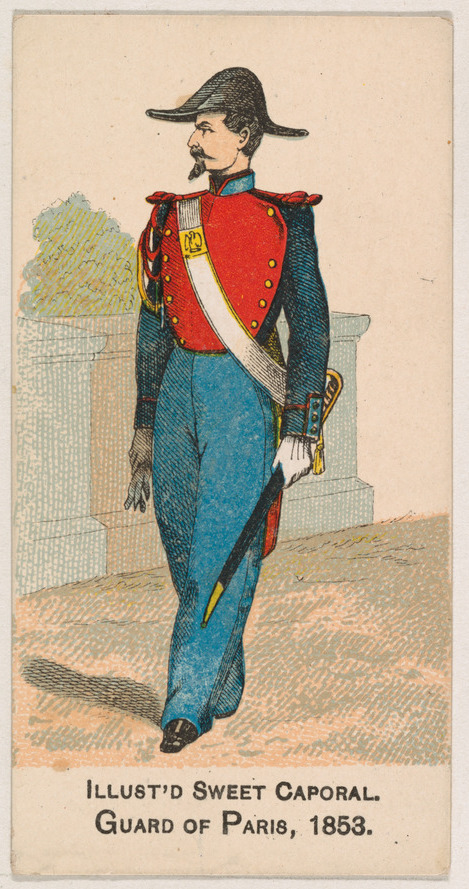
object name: print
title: Guard of Paris, 1853, from the Military Series (N224) issued by Kinney Tobacco Company to promote Sweet Caporal Cigarettes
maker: kinney brothers tobacco company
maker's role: publisher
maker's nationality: american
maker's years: 1869-2011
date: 1888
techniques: color lithograph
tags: soldiers,men,profiles